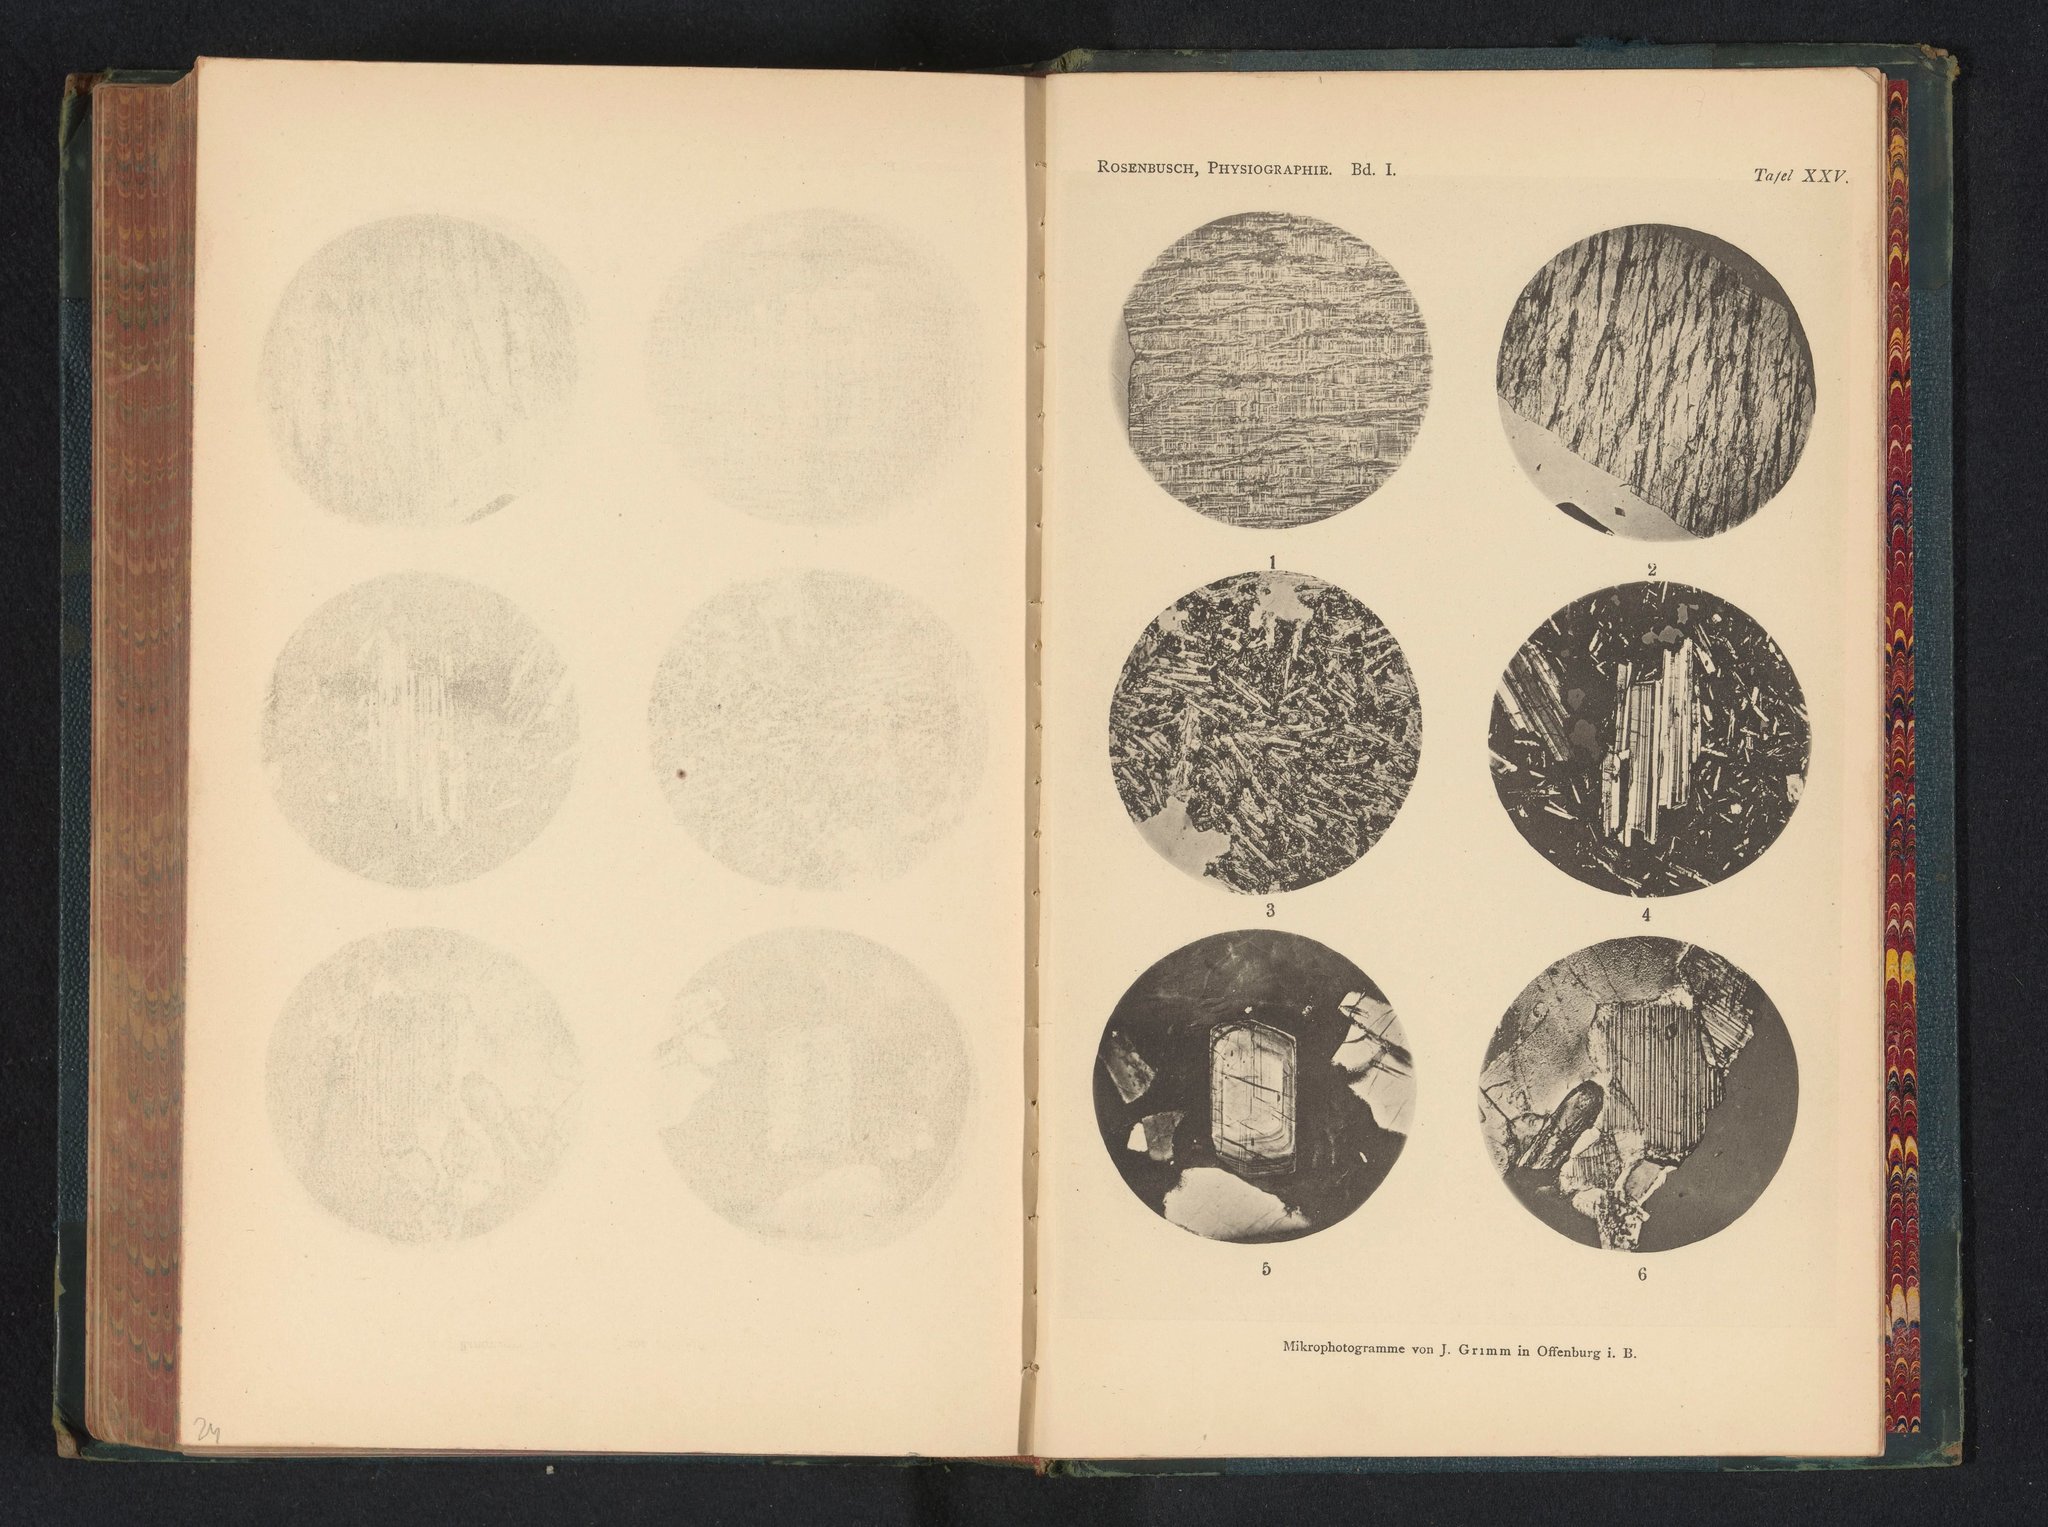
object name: photomechanical print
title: Zes microscopische vergrotingen van mineralen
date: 1880-1885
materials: paper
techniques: photograph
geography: greifswald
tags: minerals and metals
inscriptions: number: ‘1 (...) 6’, number: ‘Tafel XXV’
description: Afbeelding 1 is mikroklien, 2 is mikrokline en albiet, 3, 4, 5 en 6 is plagioklaas.